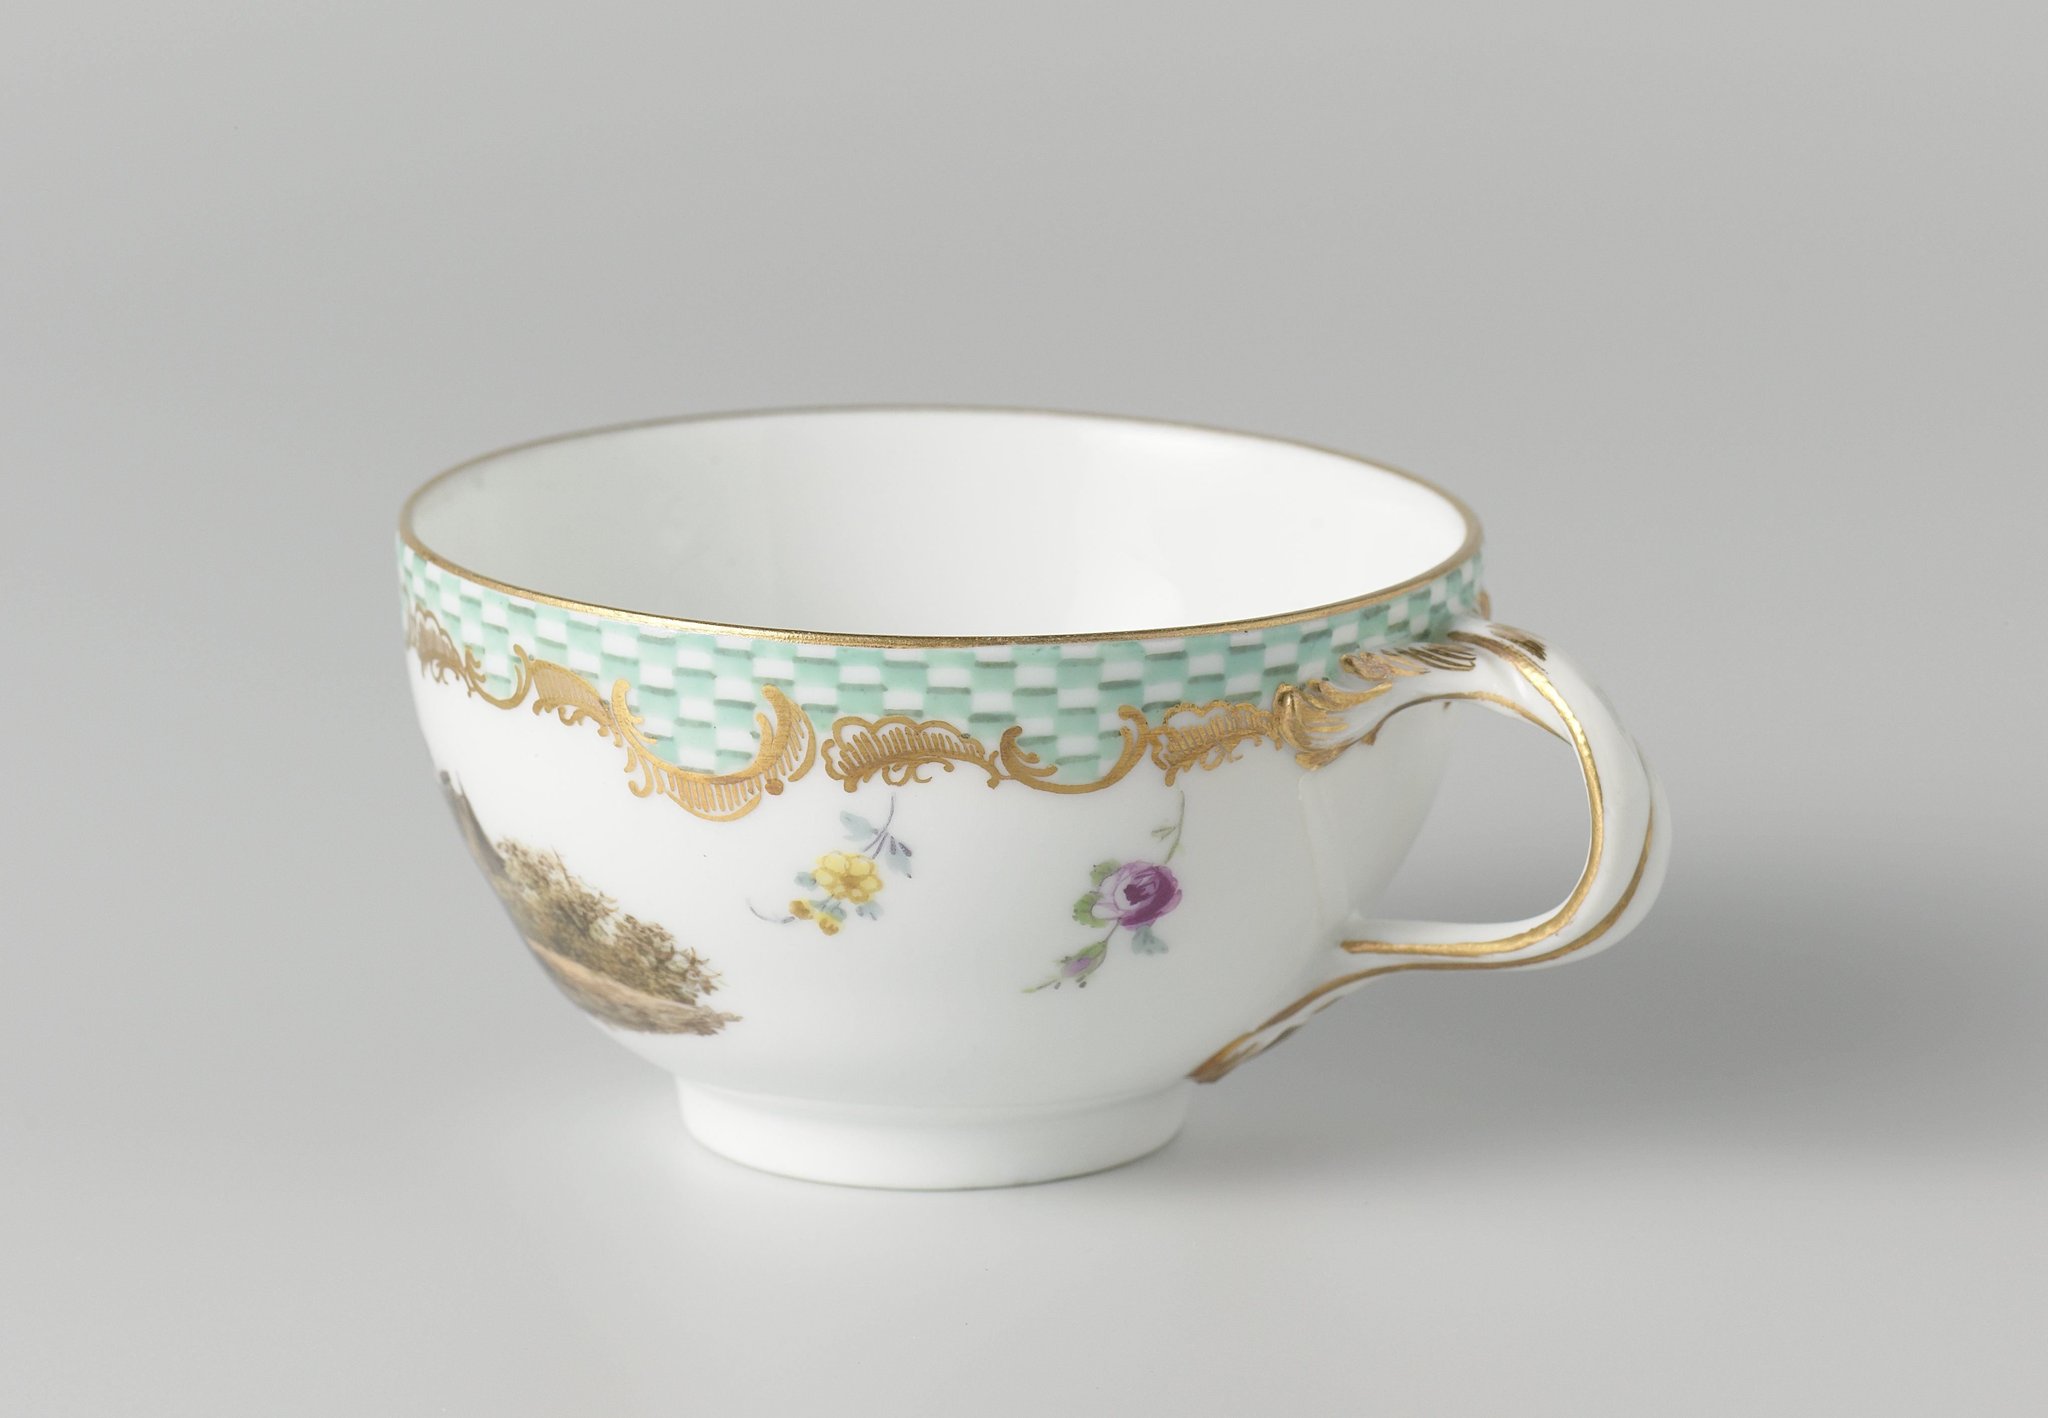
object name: cup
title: Kop, veelkleurig beschilderd met een landschap met figuren.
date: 1777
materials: porcelain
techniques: painted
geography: meissen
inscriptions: factory mark, mold mark: ‘18’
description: Lage kop met oor, van beschilderd porselein. De kop is beschilderd met landschappen waarin figuren en langs de rand een brede strook groen vlechtwerk. De kop is gemerkt.